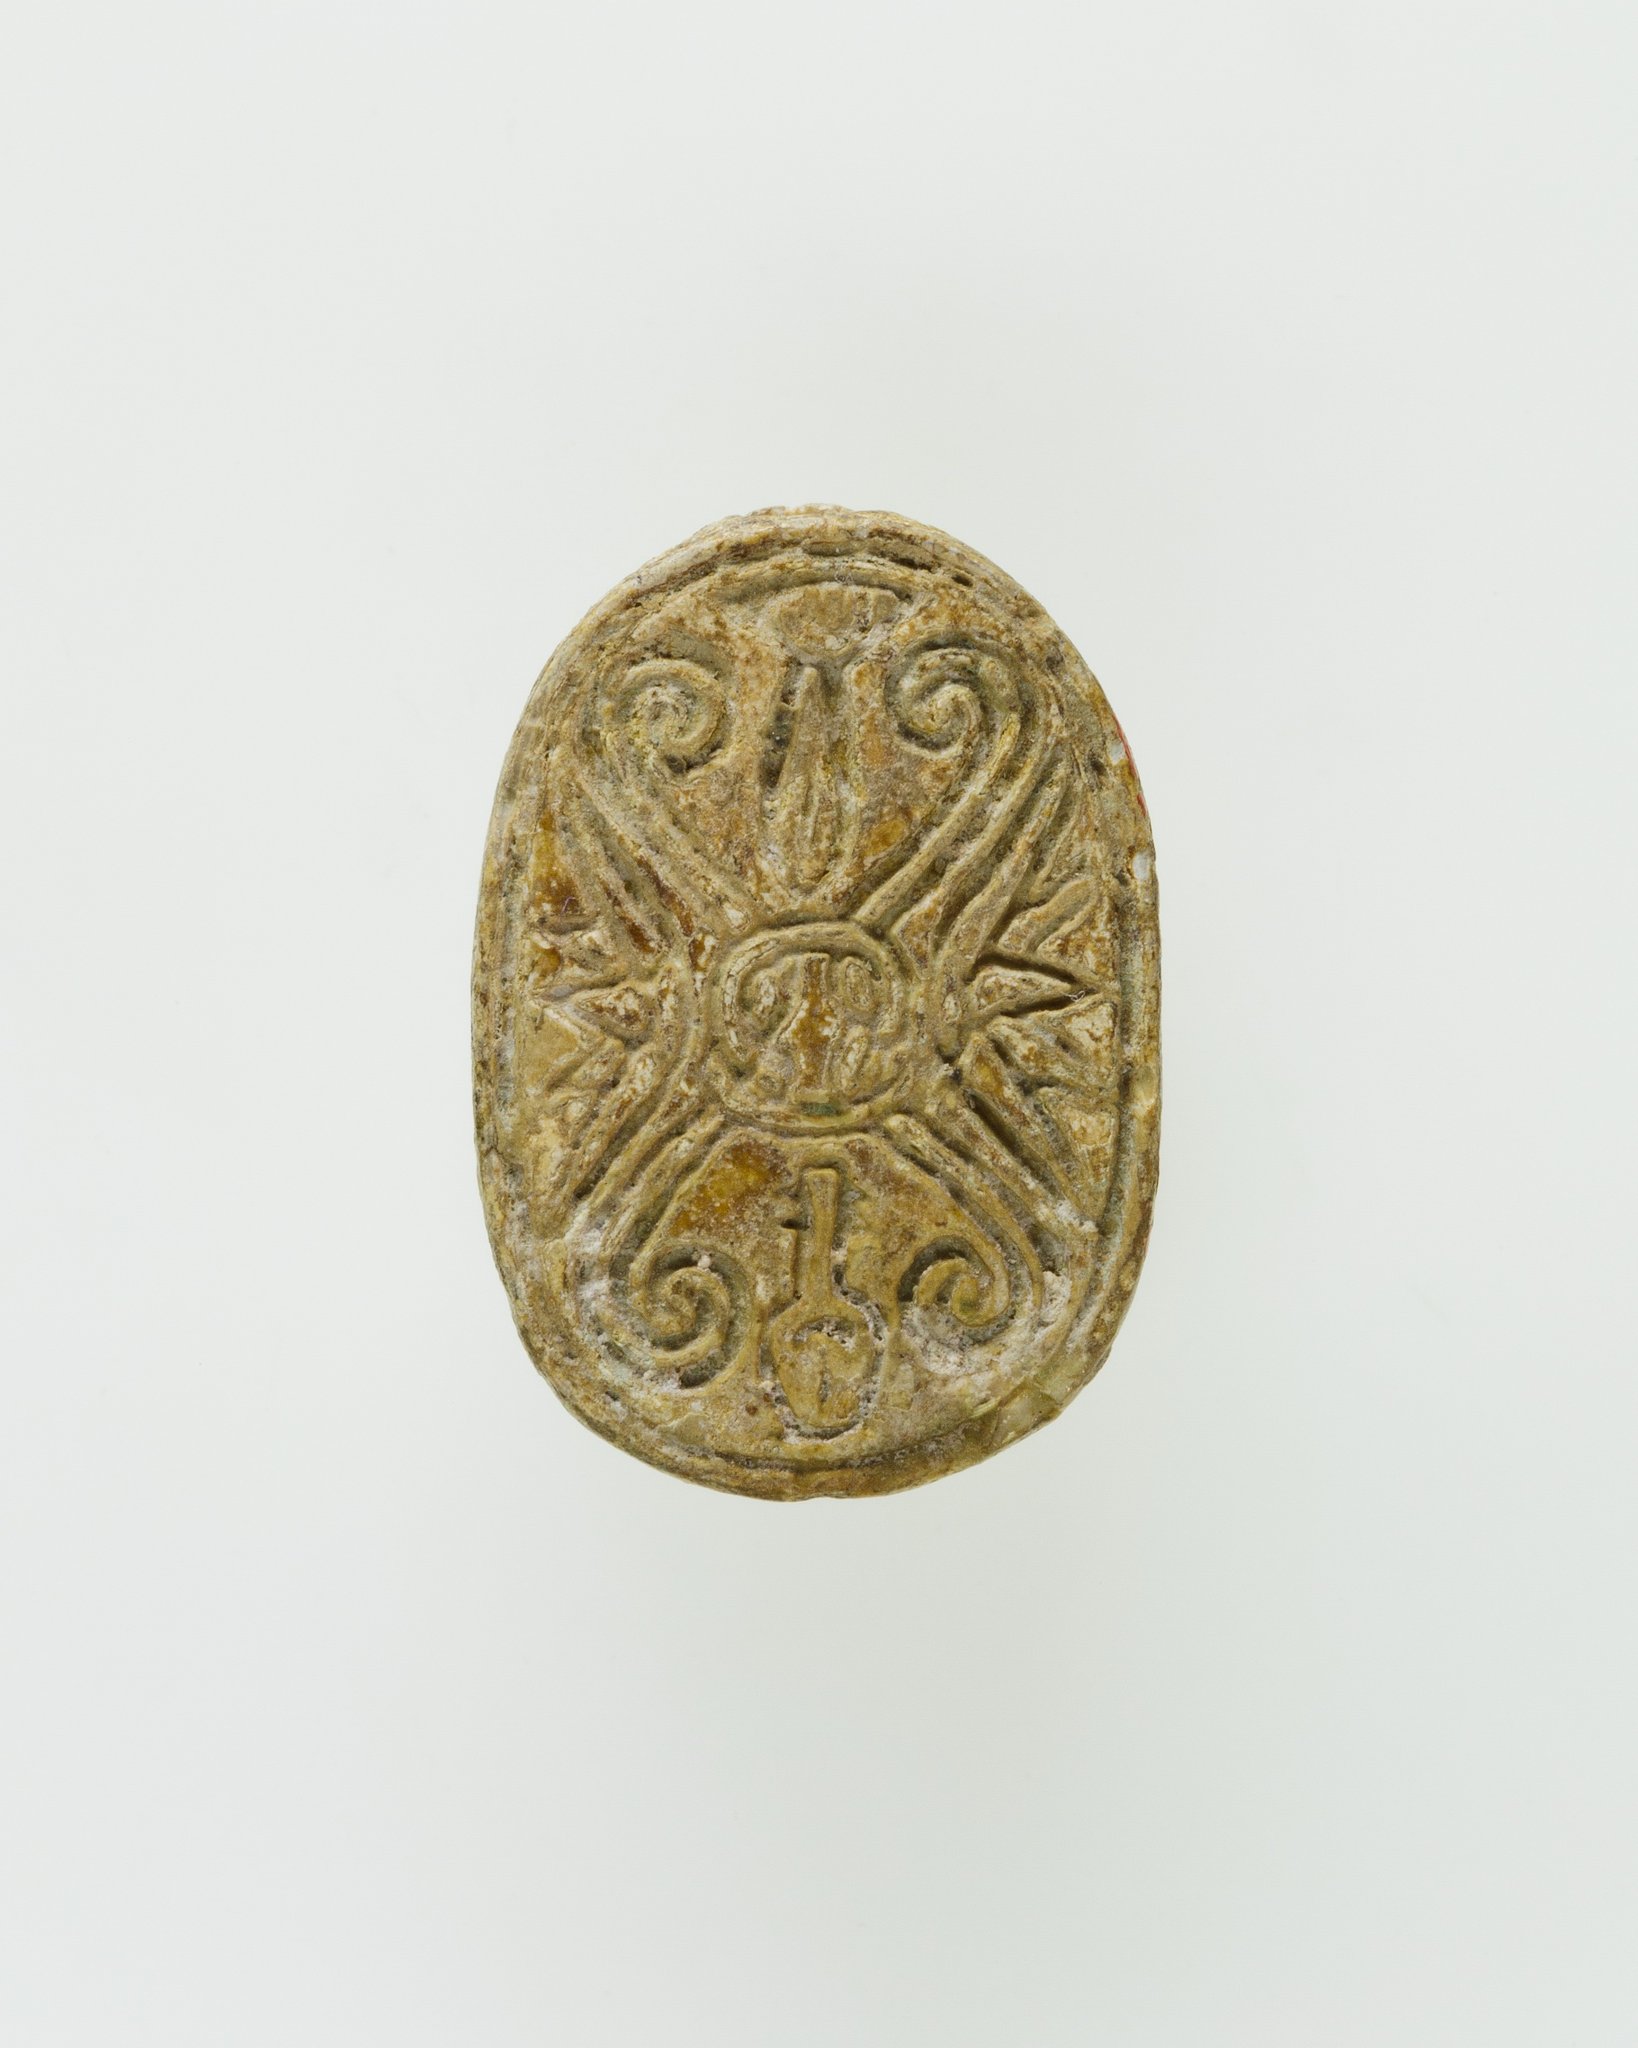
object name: scarab, convoluted coil, scroll wadj, nefer, lotus flower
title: Scarab Incised with Hieroglyphs and a Cruciform Design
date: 1760-1670 BCE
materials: glaze, stone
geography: egypt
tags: scarabs